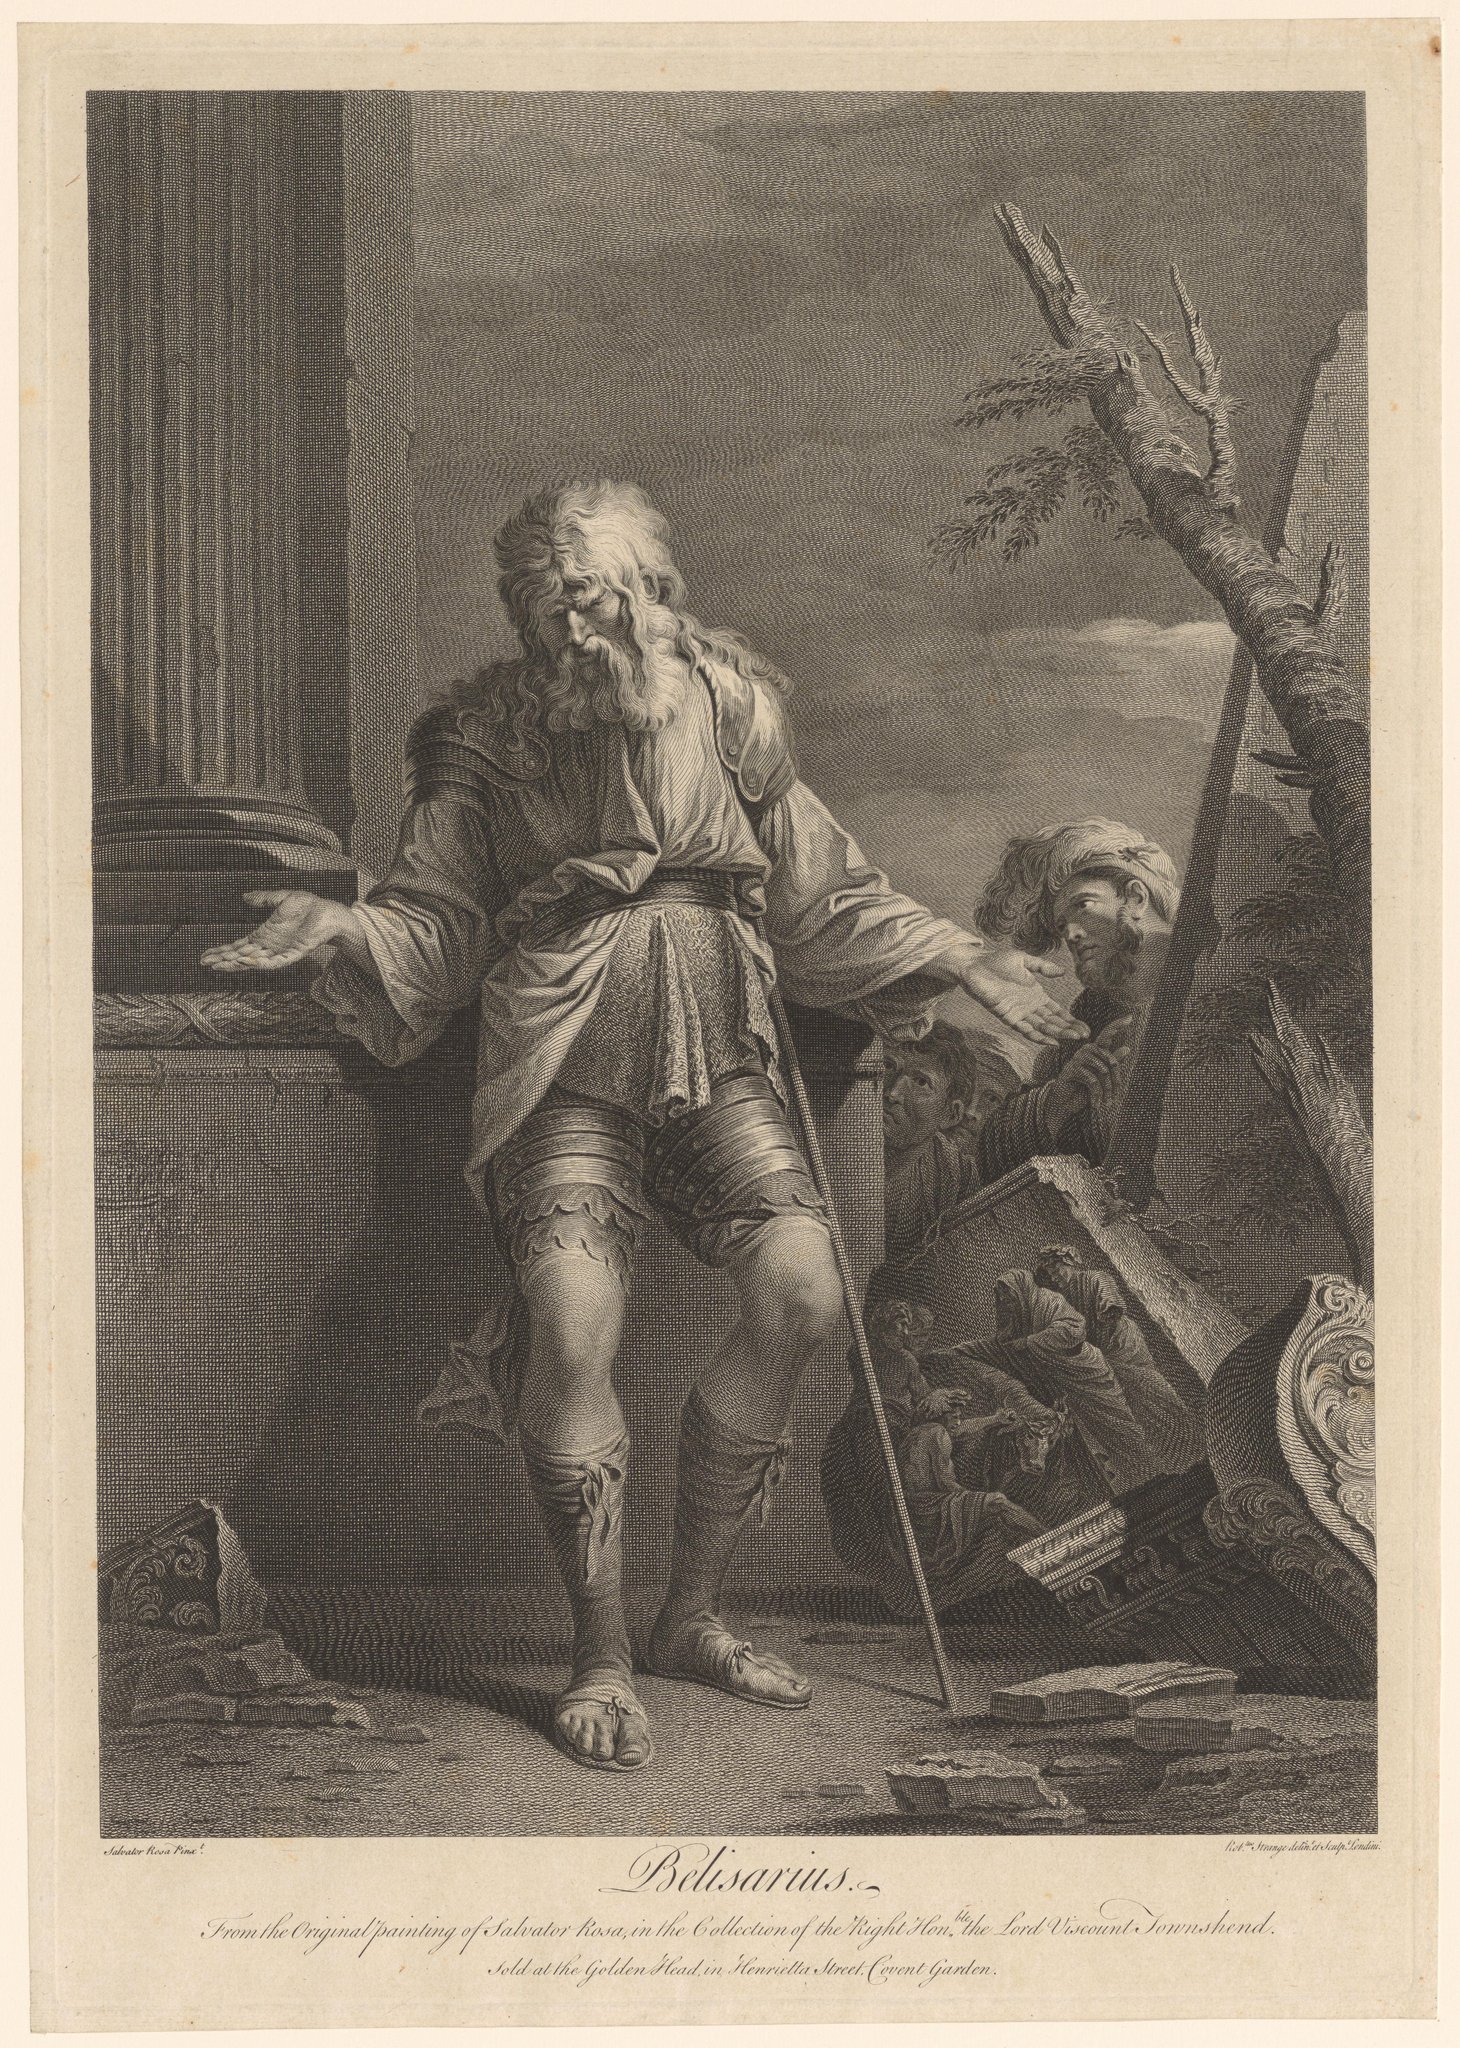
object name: print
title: Belisarius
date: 1756-1757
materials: paper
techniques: engraving, etching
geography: london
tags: beggar, belisarius, ruin of a dwelling, house, castle, etc.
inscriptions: collector's mark: Lugt 2228